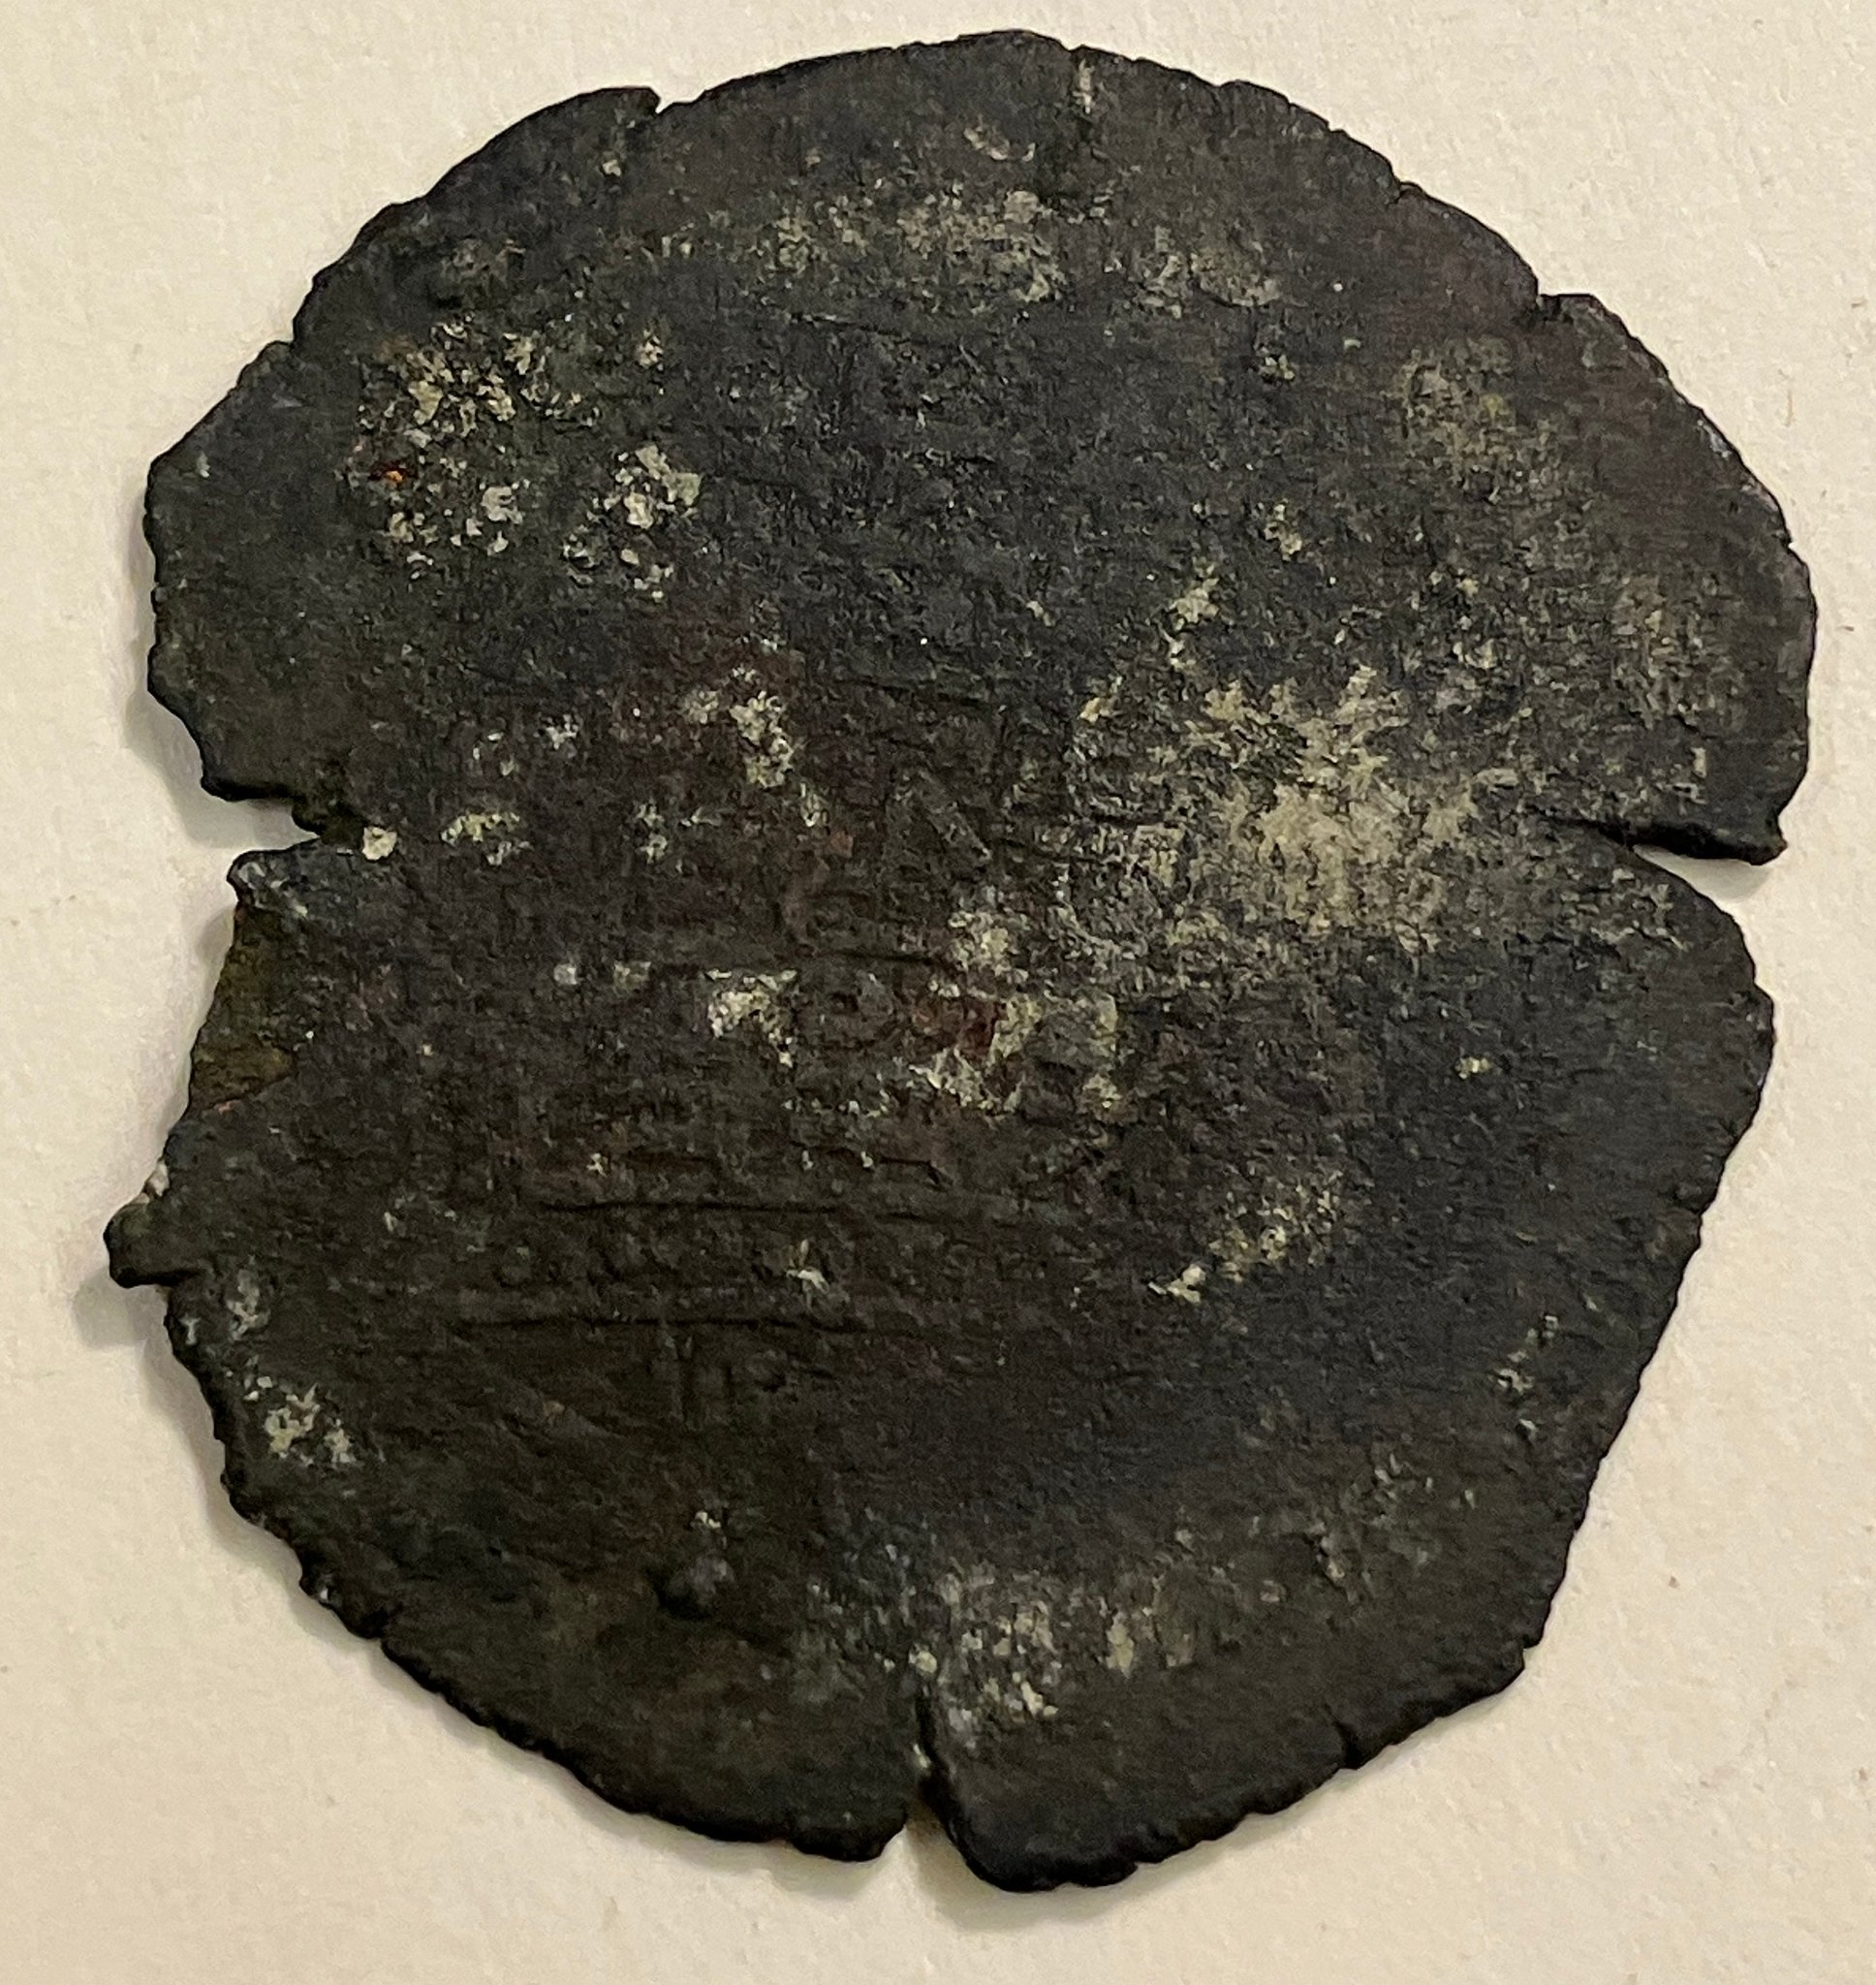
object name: coin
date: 401-1400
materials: copper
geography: iran